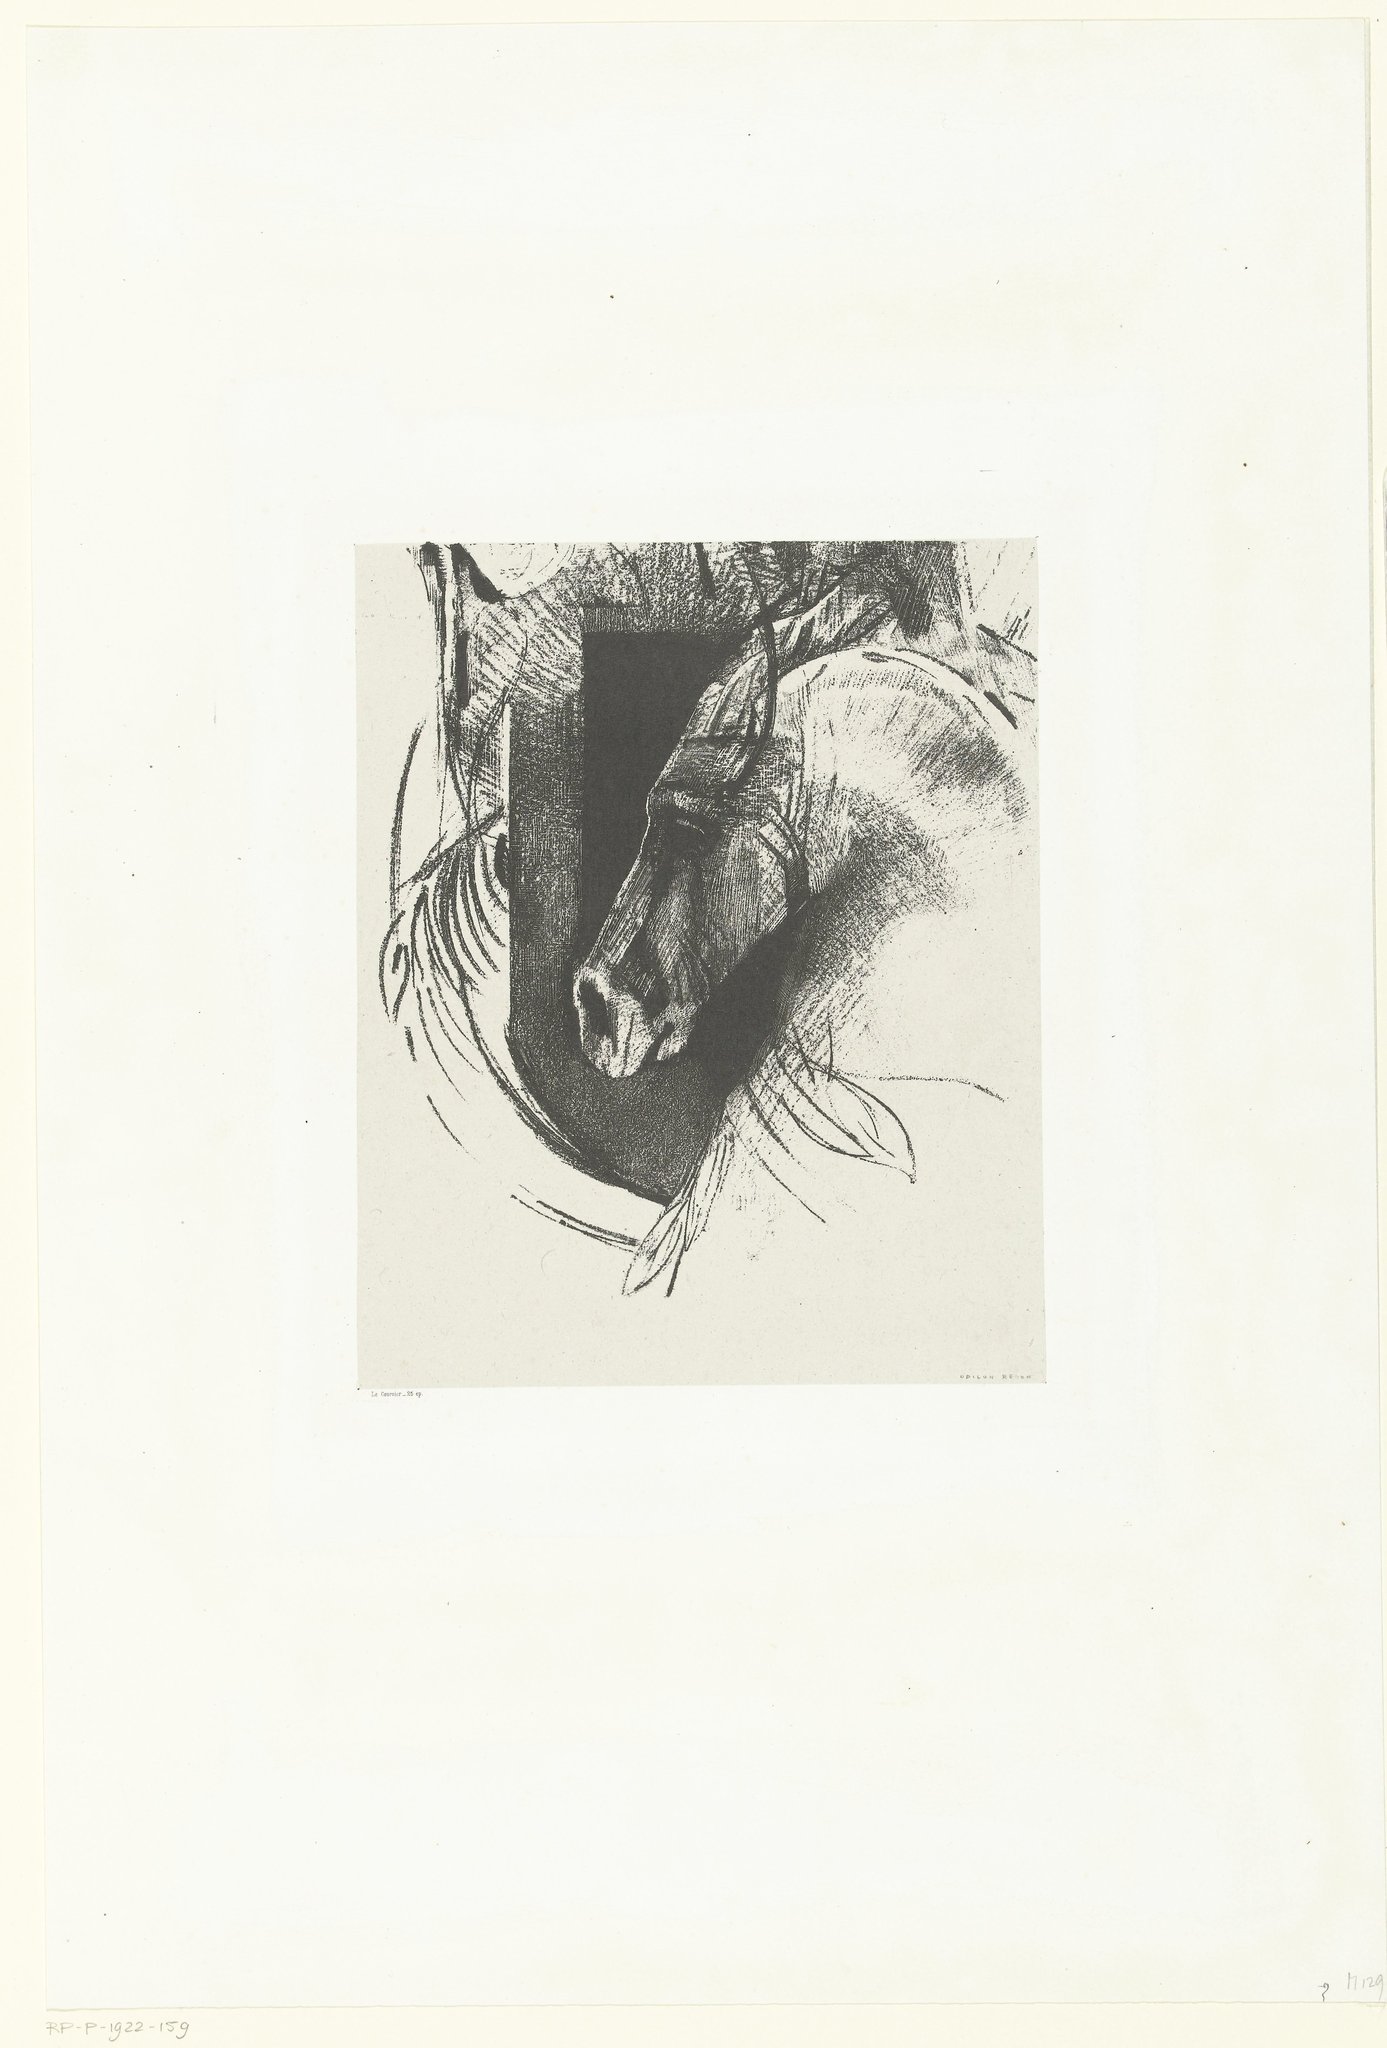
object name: print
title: Strijdros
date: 1894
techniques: printmaking, lithograph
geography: paris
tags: horse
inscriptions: collector's mark: Lugt 2228